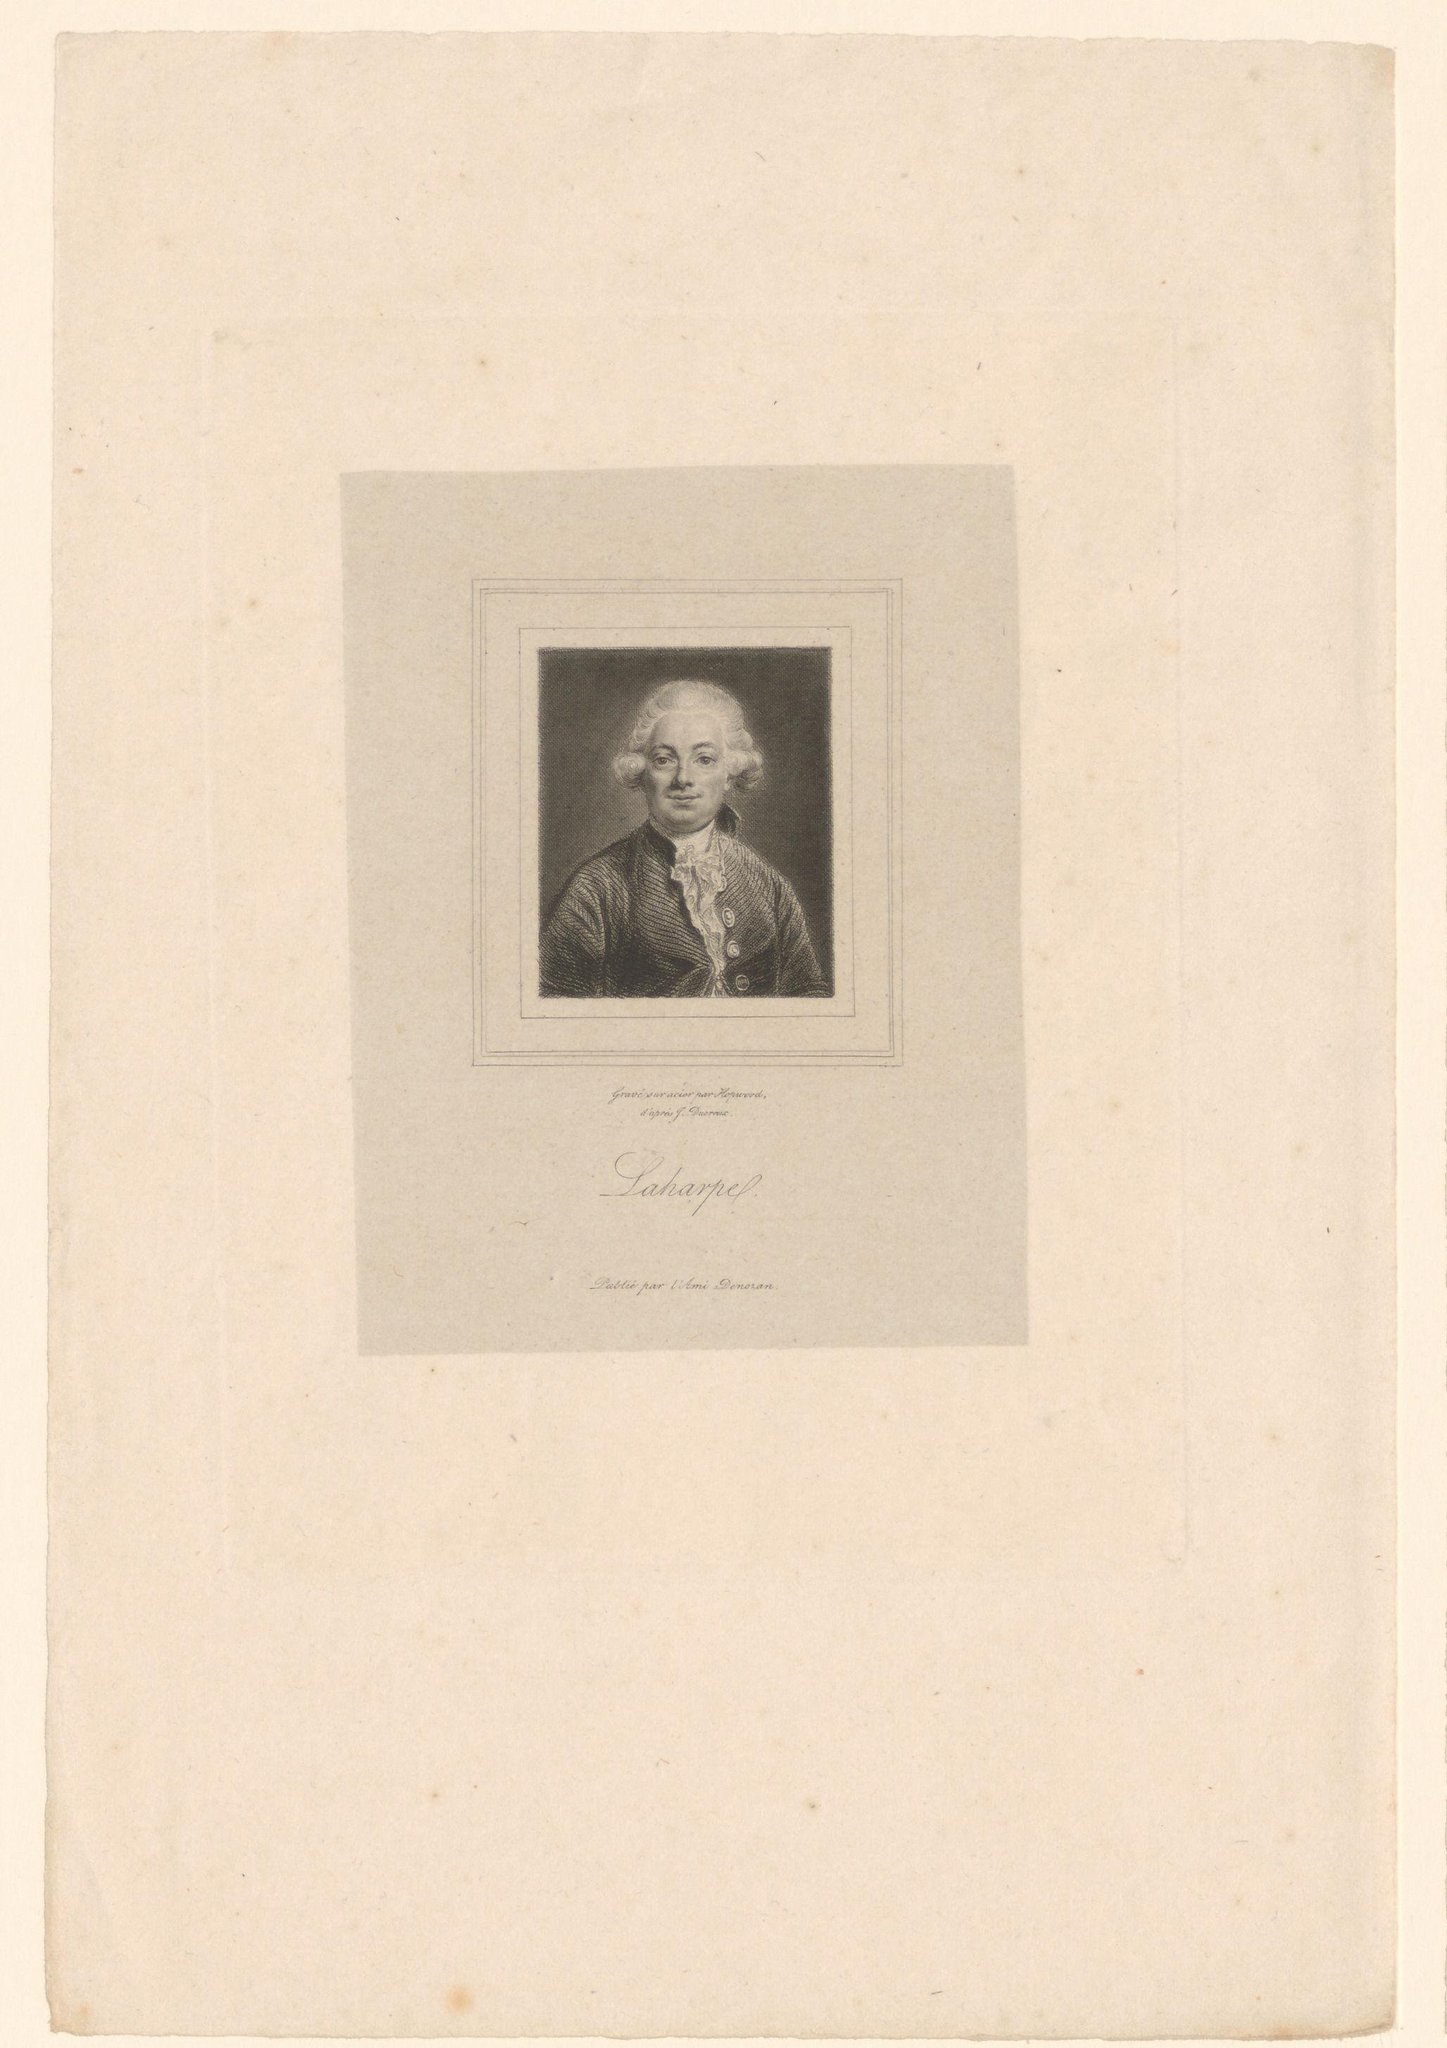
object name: print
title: Laharpe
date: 1828-1850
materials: paper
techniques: etching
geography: paris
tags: paris, historical persons, portrait of a writer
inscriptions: collector's mark: Lugt 2228